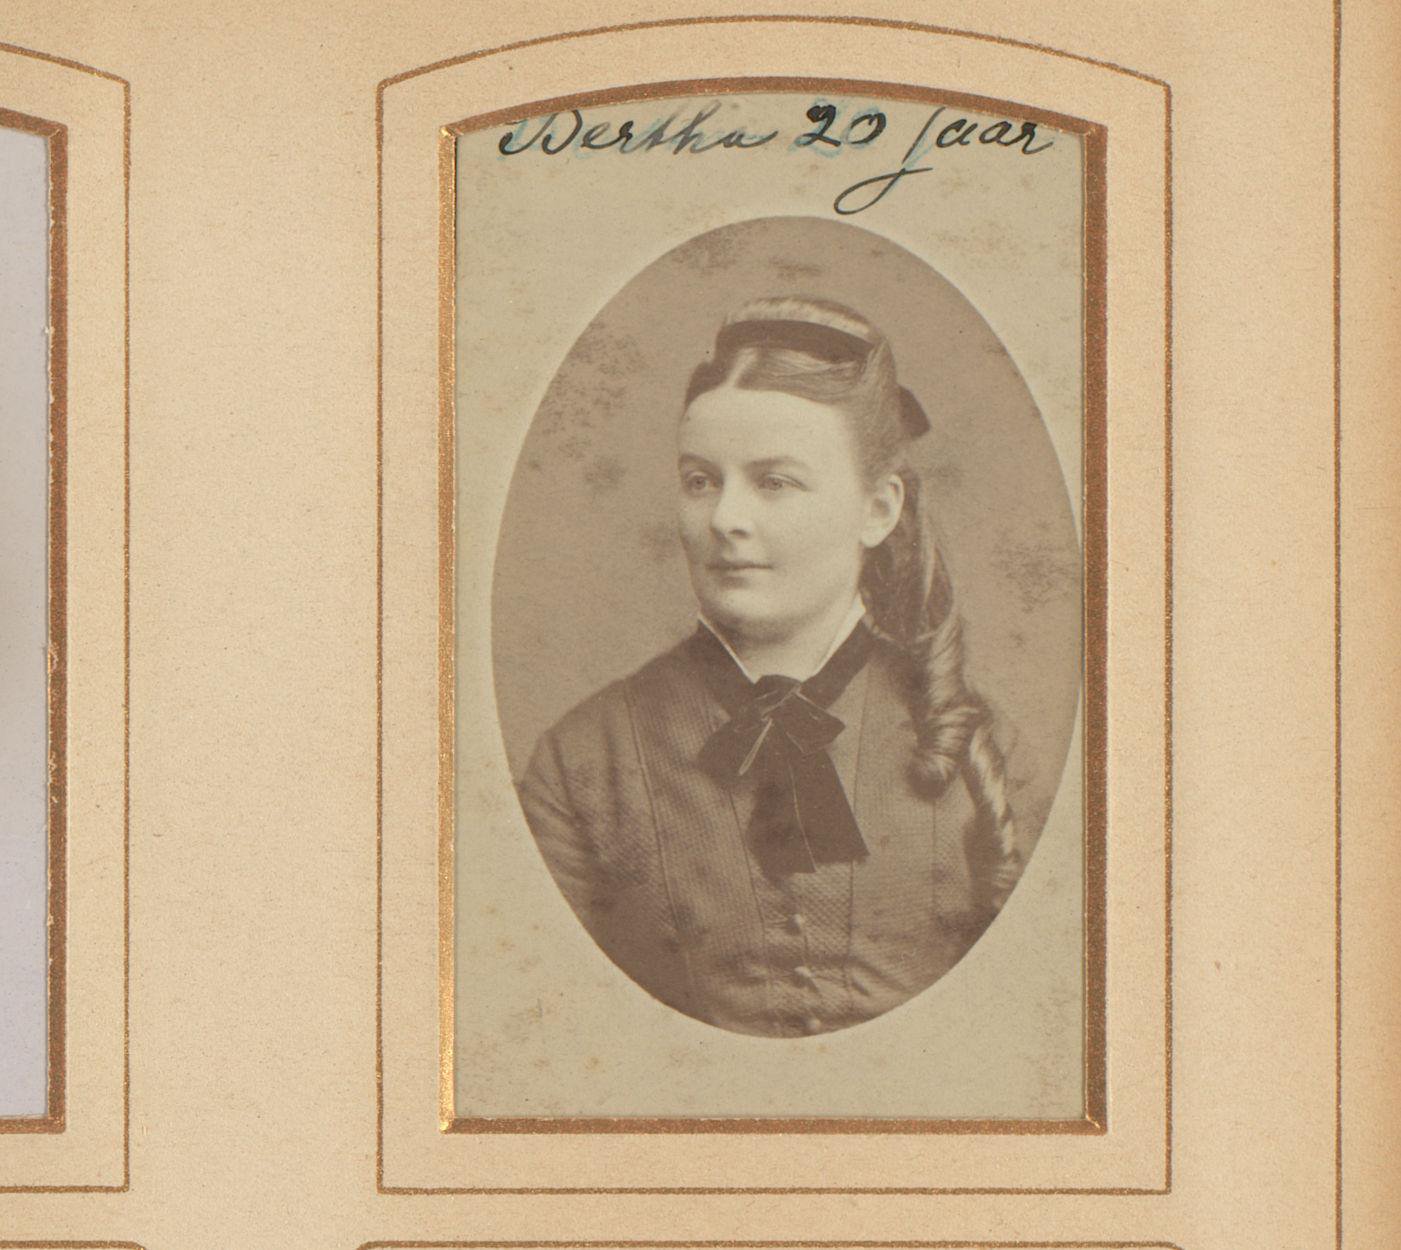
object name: album leaf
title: Portret van een jonge vrouw, aangeduid als Bertha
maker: Anonymous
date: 1870-1900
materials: cardboard, photographic support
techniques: albumen print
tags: adolescent, young woman, maiden, historical persons - bb - woman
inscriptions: annotation: ‘Bertha 20 jaar’